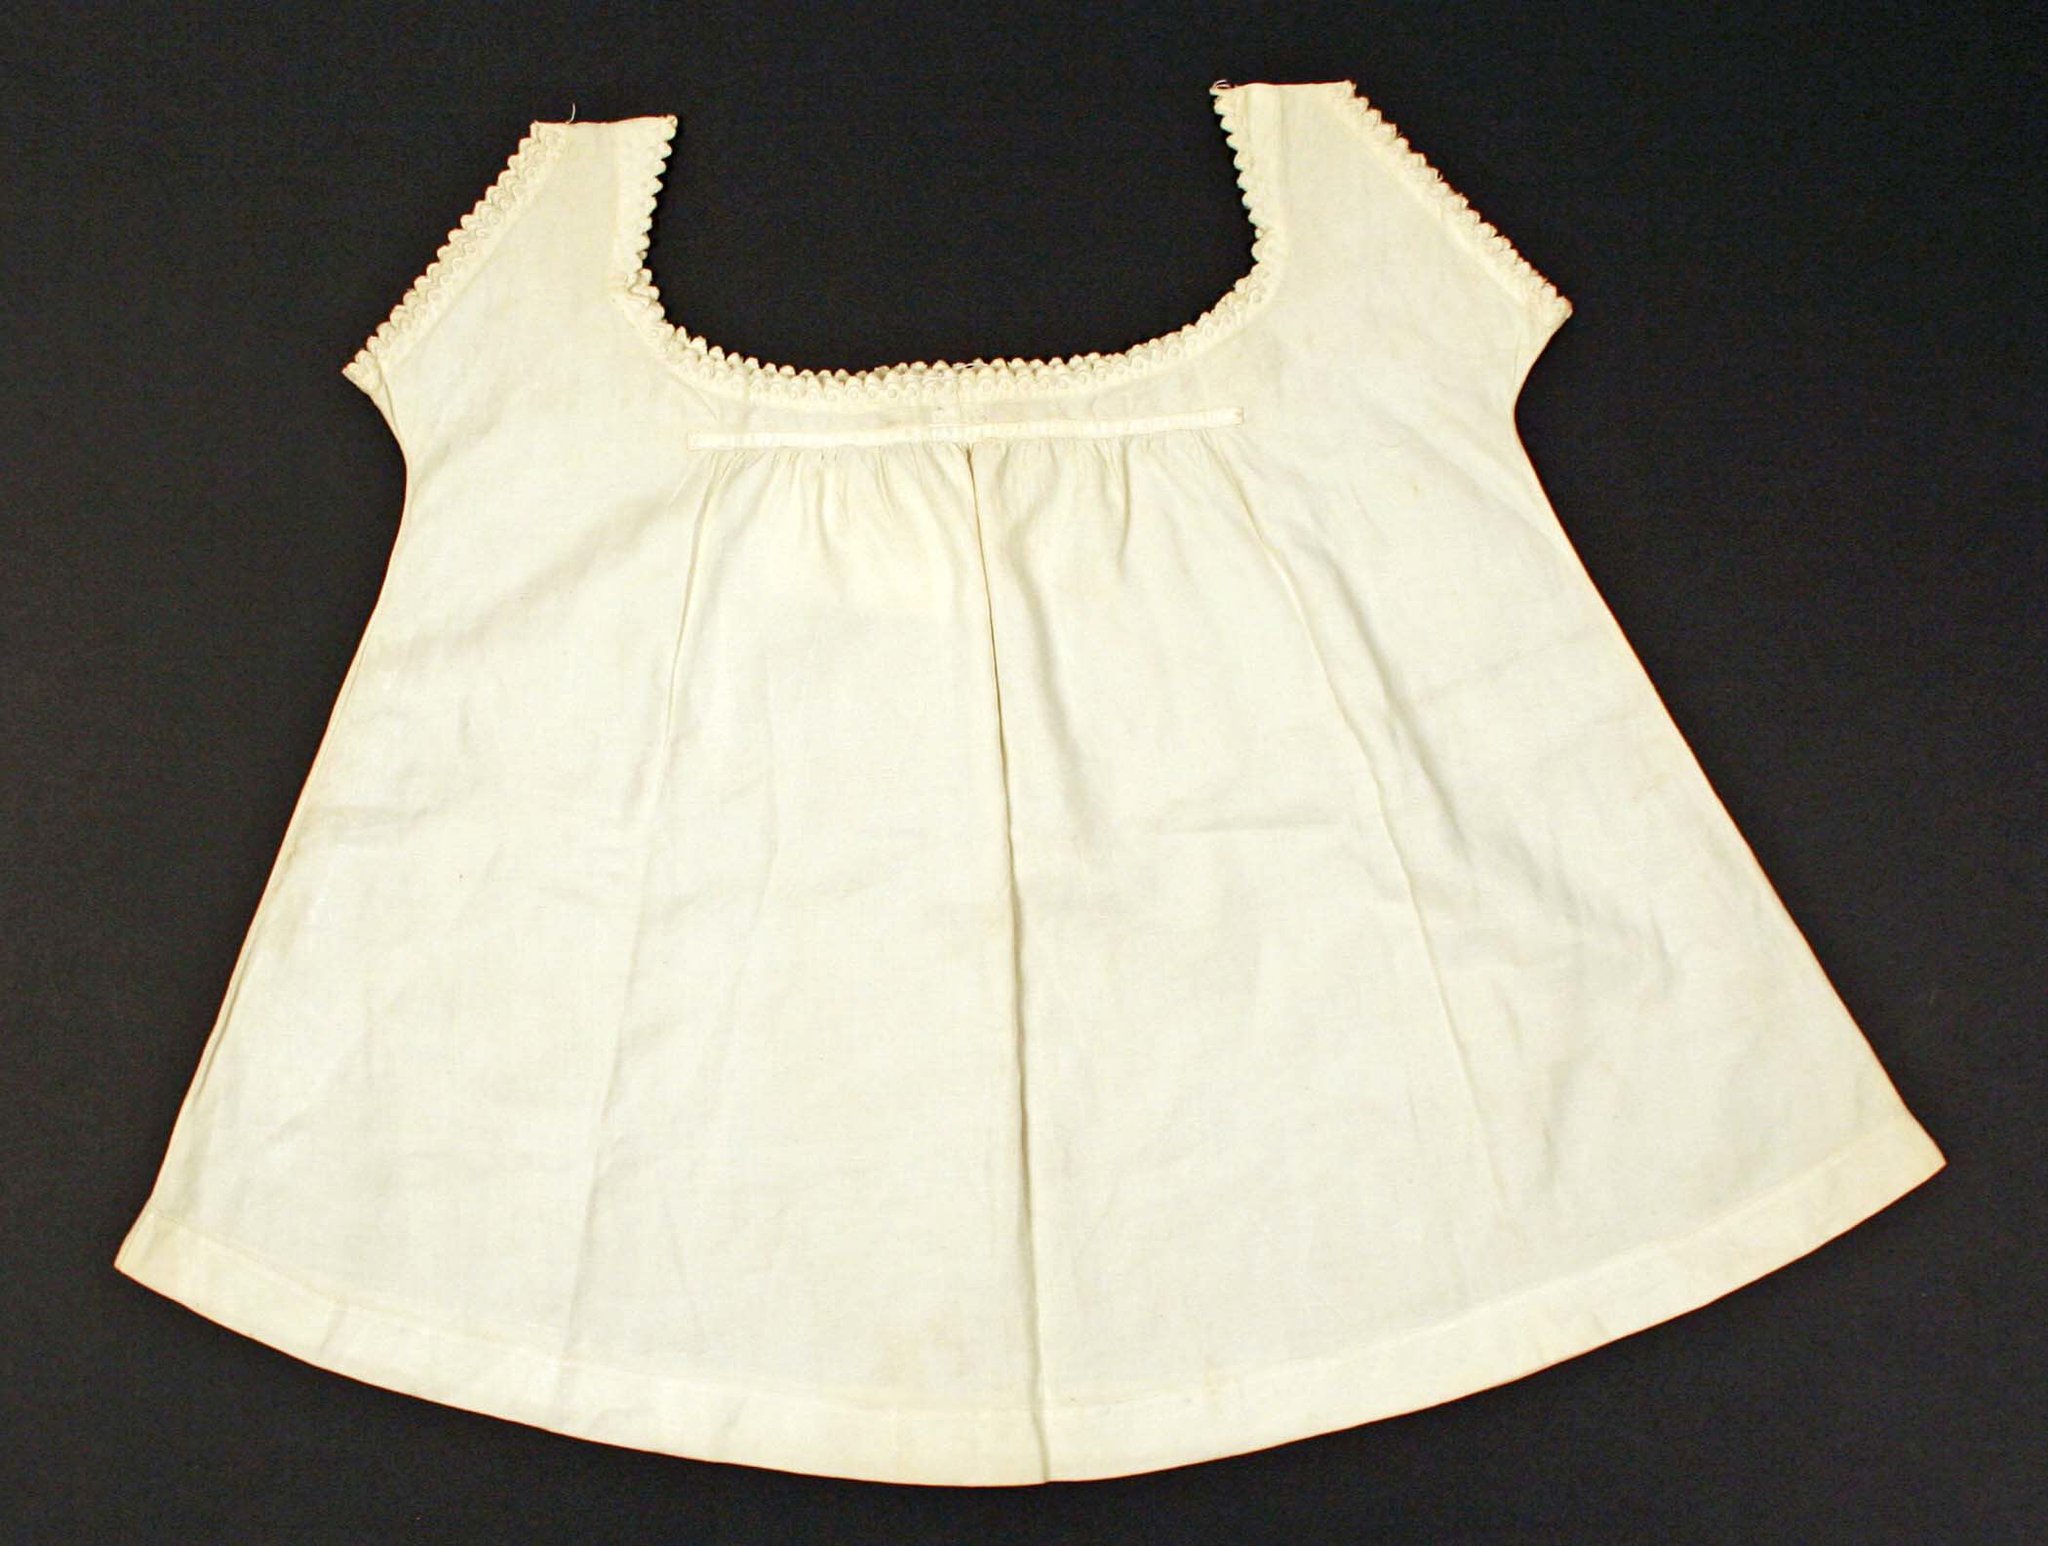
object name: slip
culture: american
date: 1880-1889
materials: linen